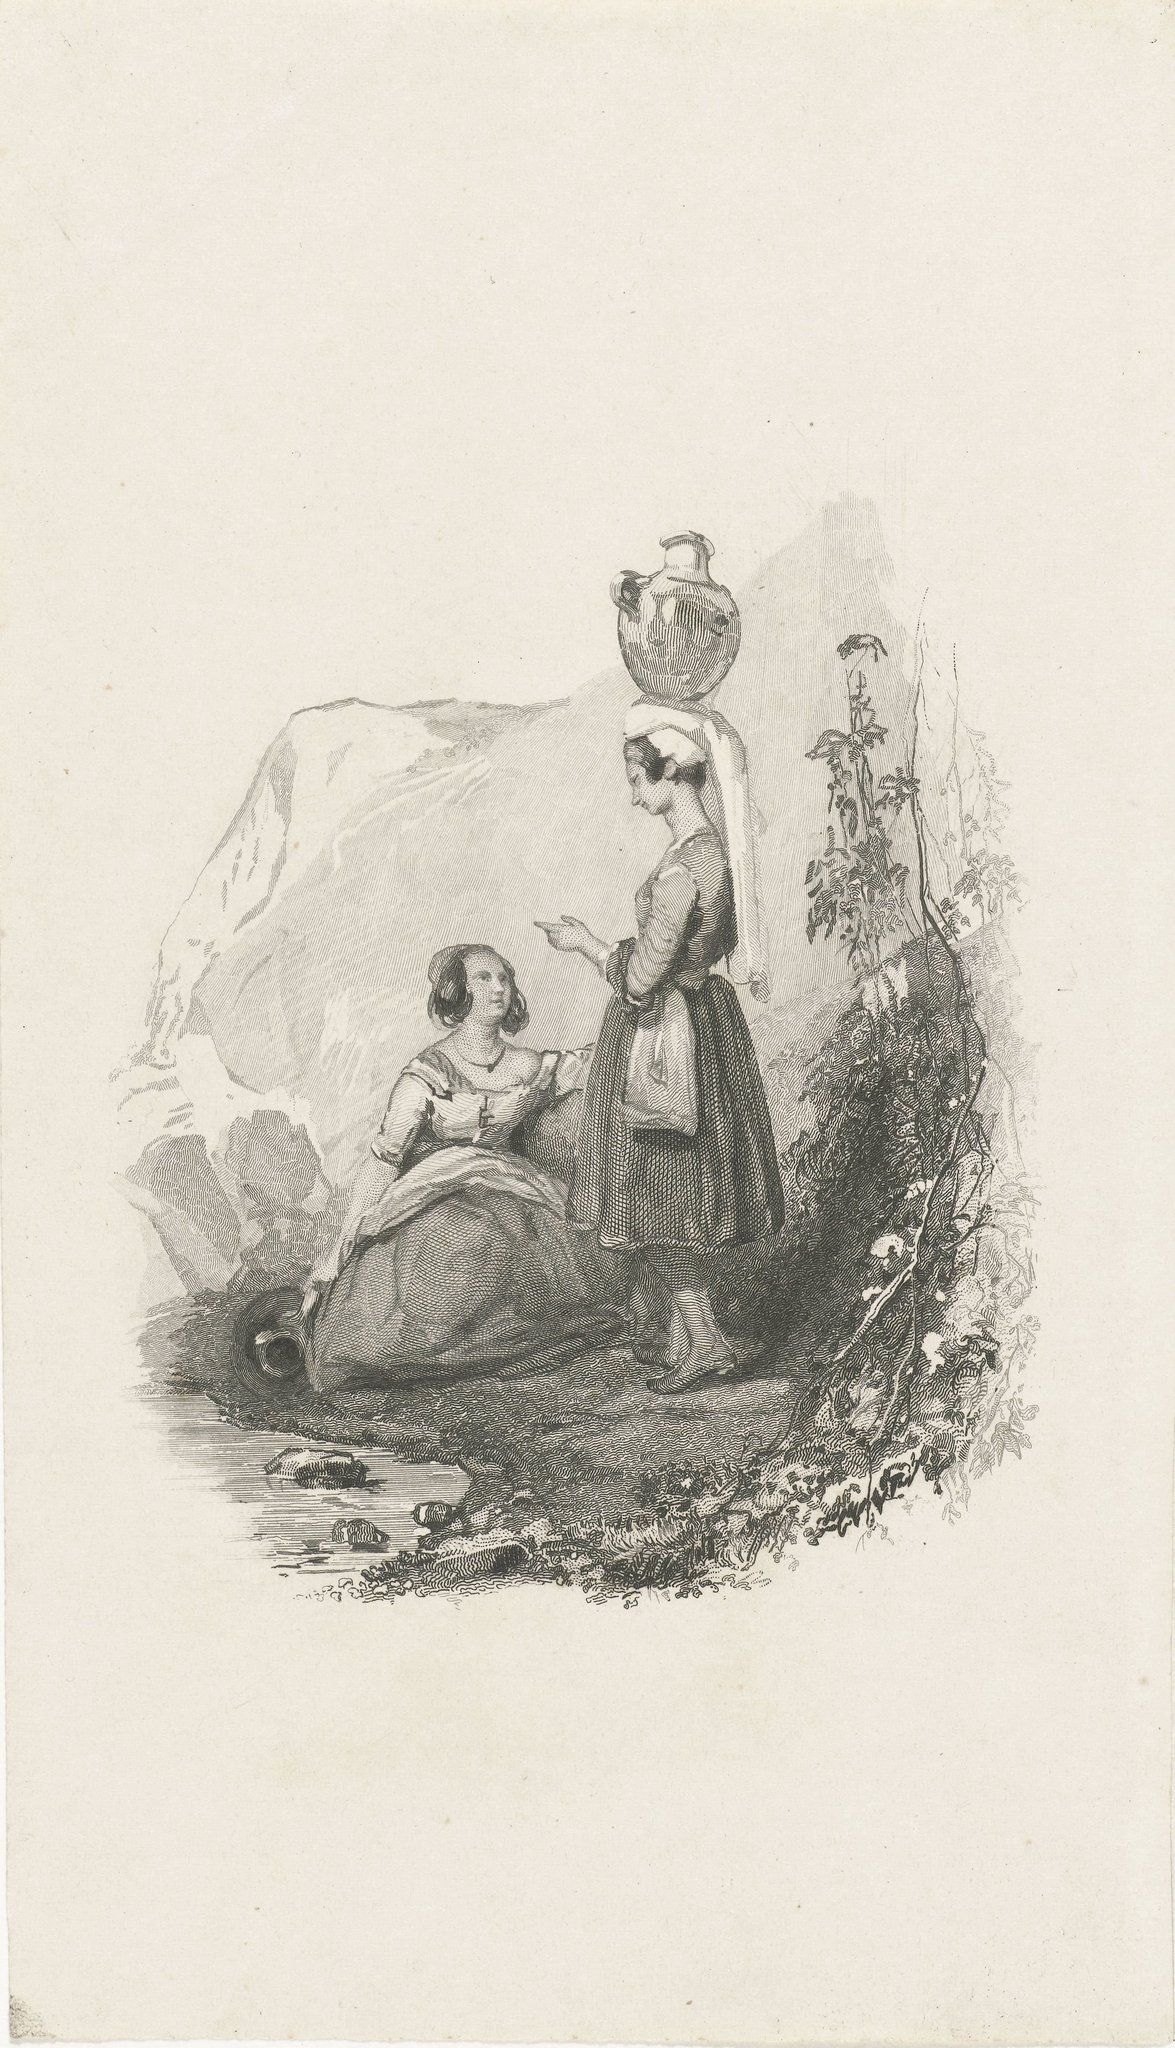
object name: book illustration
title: Twee waterdraagsters rusten uit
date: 1830-1845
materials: paper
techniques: engraving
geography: amsterdam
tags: resting - bb - out of doors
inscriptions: collector's mark: Lugt 2228